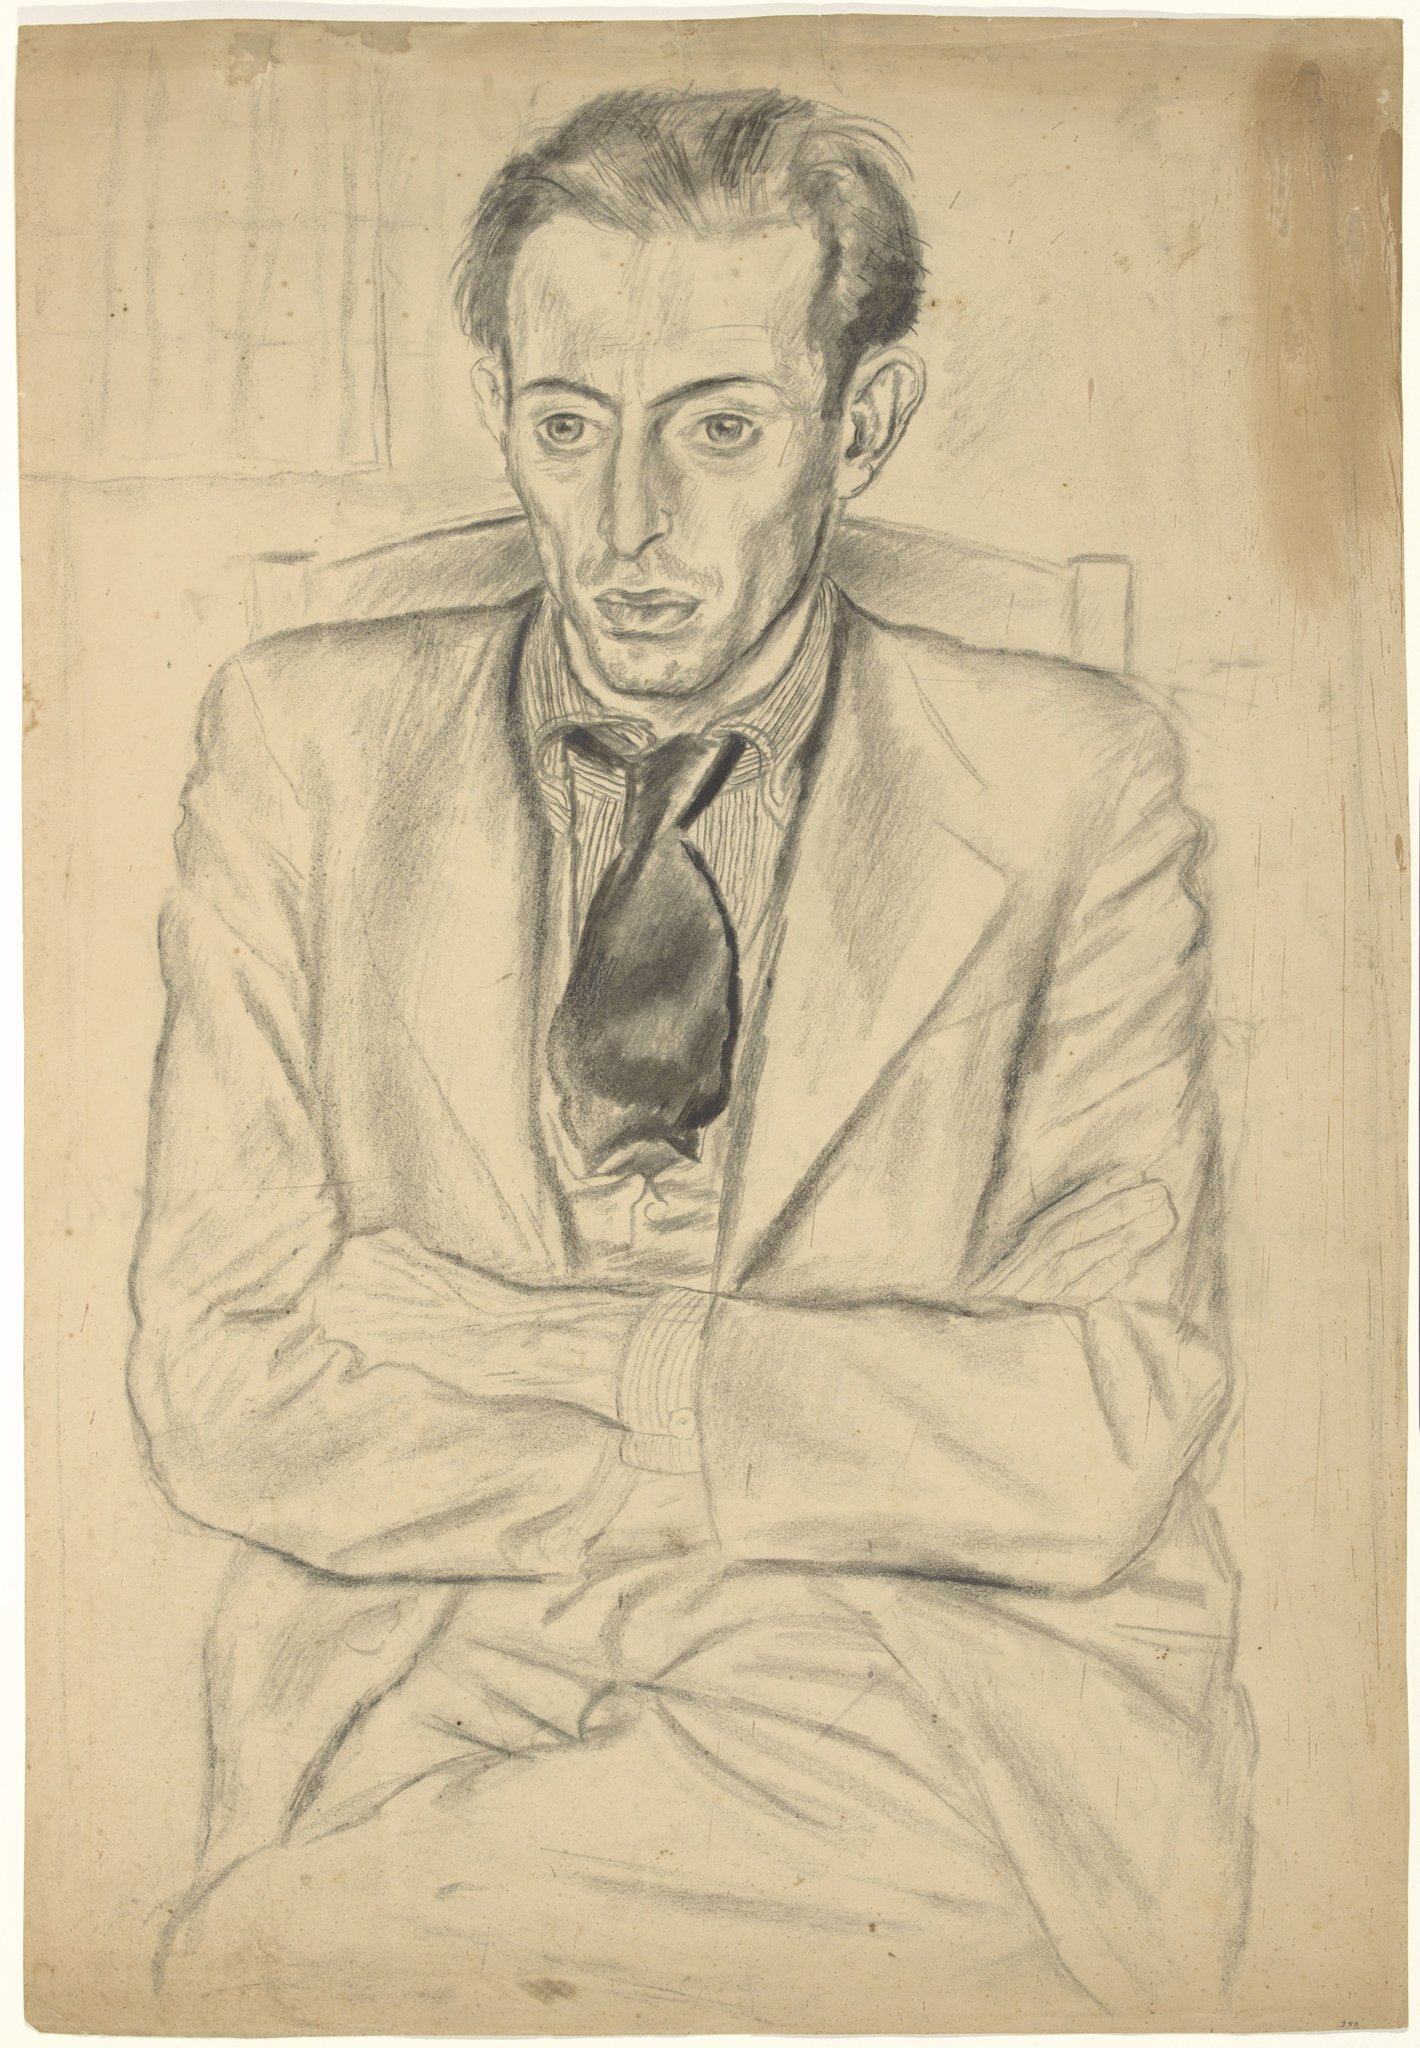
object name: drawing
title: Portret van een zittende man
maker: henk henriët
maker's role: draughtsman, print maker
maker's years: 1903-1945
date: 1918-1945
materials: chalk, charcoal, paper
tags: historical persons not known by name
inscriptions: number: ‘250’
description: Portret van een zittende man, gekleed in een kostuum, streepjes overhemd en stropdas. Hij heeft zijn armen over elkaar geslagen.